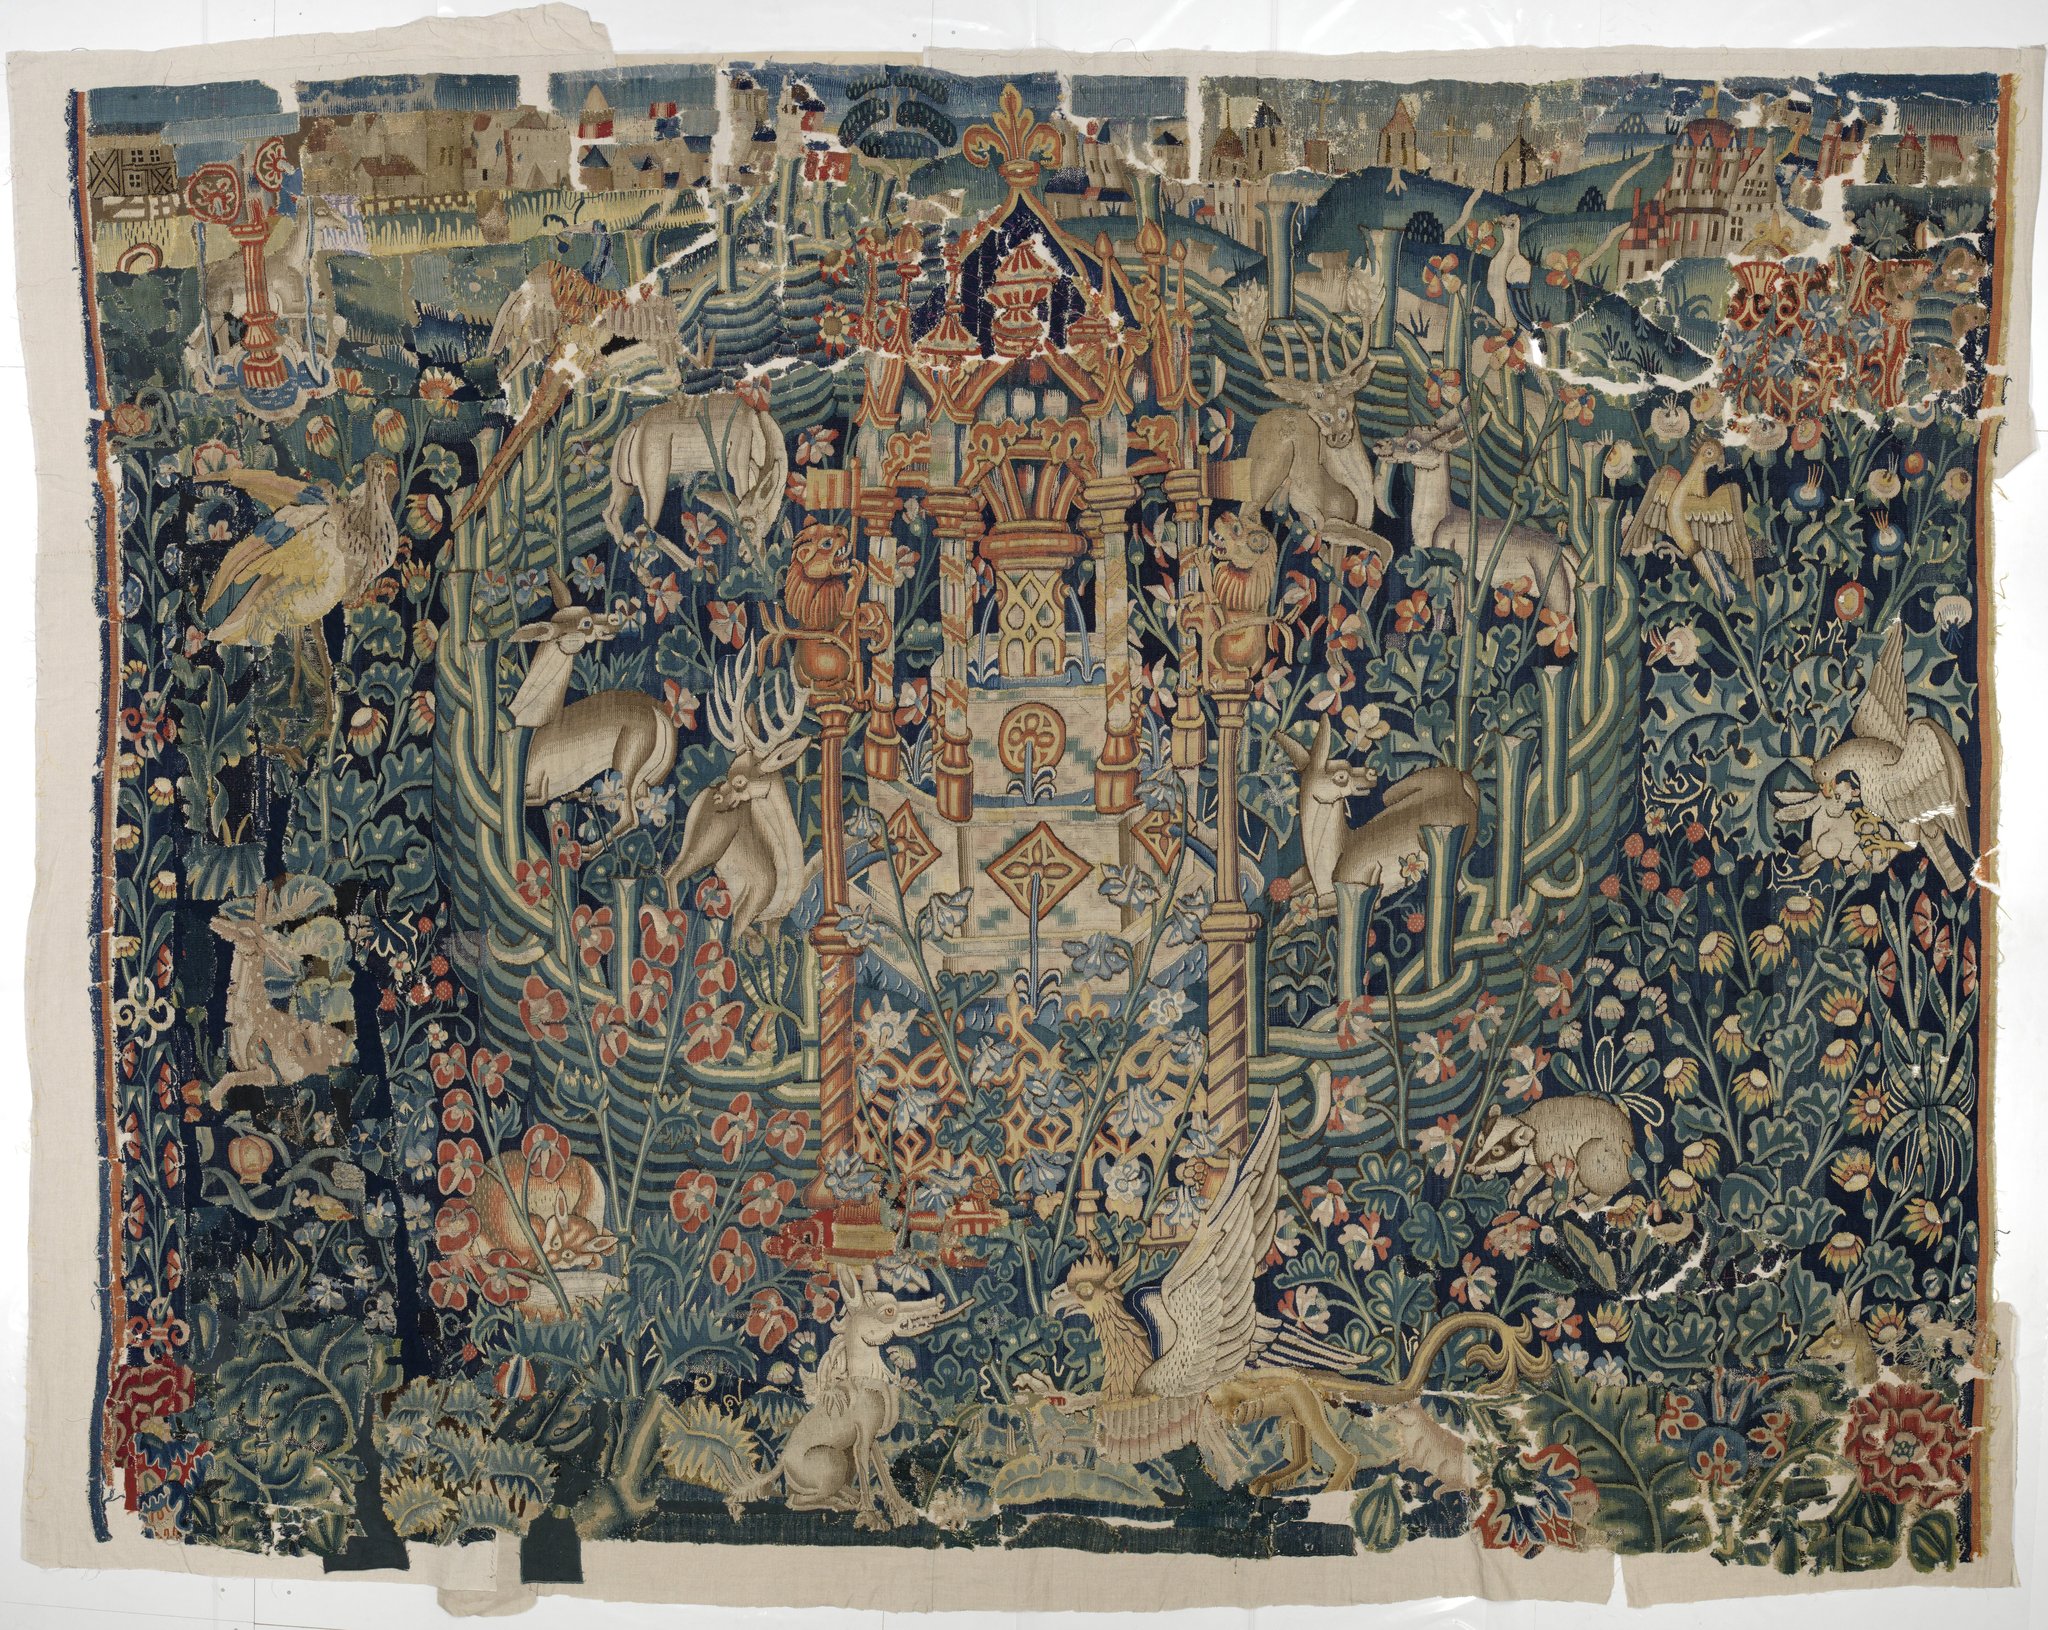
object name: verdure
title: Verdure met dieren, een besloten tuin en een levensbron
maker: Anonymous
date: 1500-1525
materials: silk, wool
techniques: tapestry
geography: southern netherlands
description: Wandtapijt, grootbladige verdure met de Hortus Conclusus en de Levensbron in een omheinde tuin. Een blauwzwart fond wordt overdekt met hoog opgroeiende bloeiende planten, waartussen wilde en fabeldieren. De licht gerande bladeren zijn groot en gevarieerd: gelobd of scherp en diep ingesneden, distelvormig of acanthussoort. De vrij kleine bloemen groeien in trossen. De dieren zijn o.a. een toegewende griffioen en wolf, voorts een vos, das, adelaar en een havik, die een konijn aanvalt. In het verschiet met huizen bebouwde heuvelen. In het centrum staat een in verdiepingen opgebouwde zeshoekige fontein, met zuiltjes, die een door Franse lelie gekroond baldakijn vormen boven een middenzuil. Alles is geel en rood. Binnen de omheining liggen ongestoord zes herten.